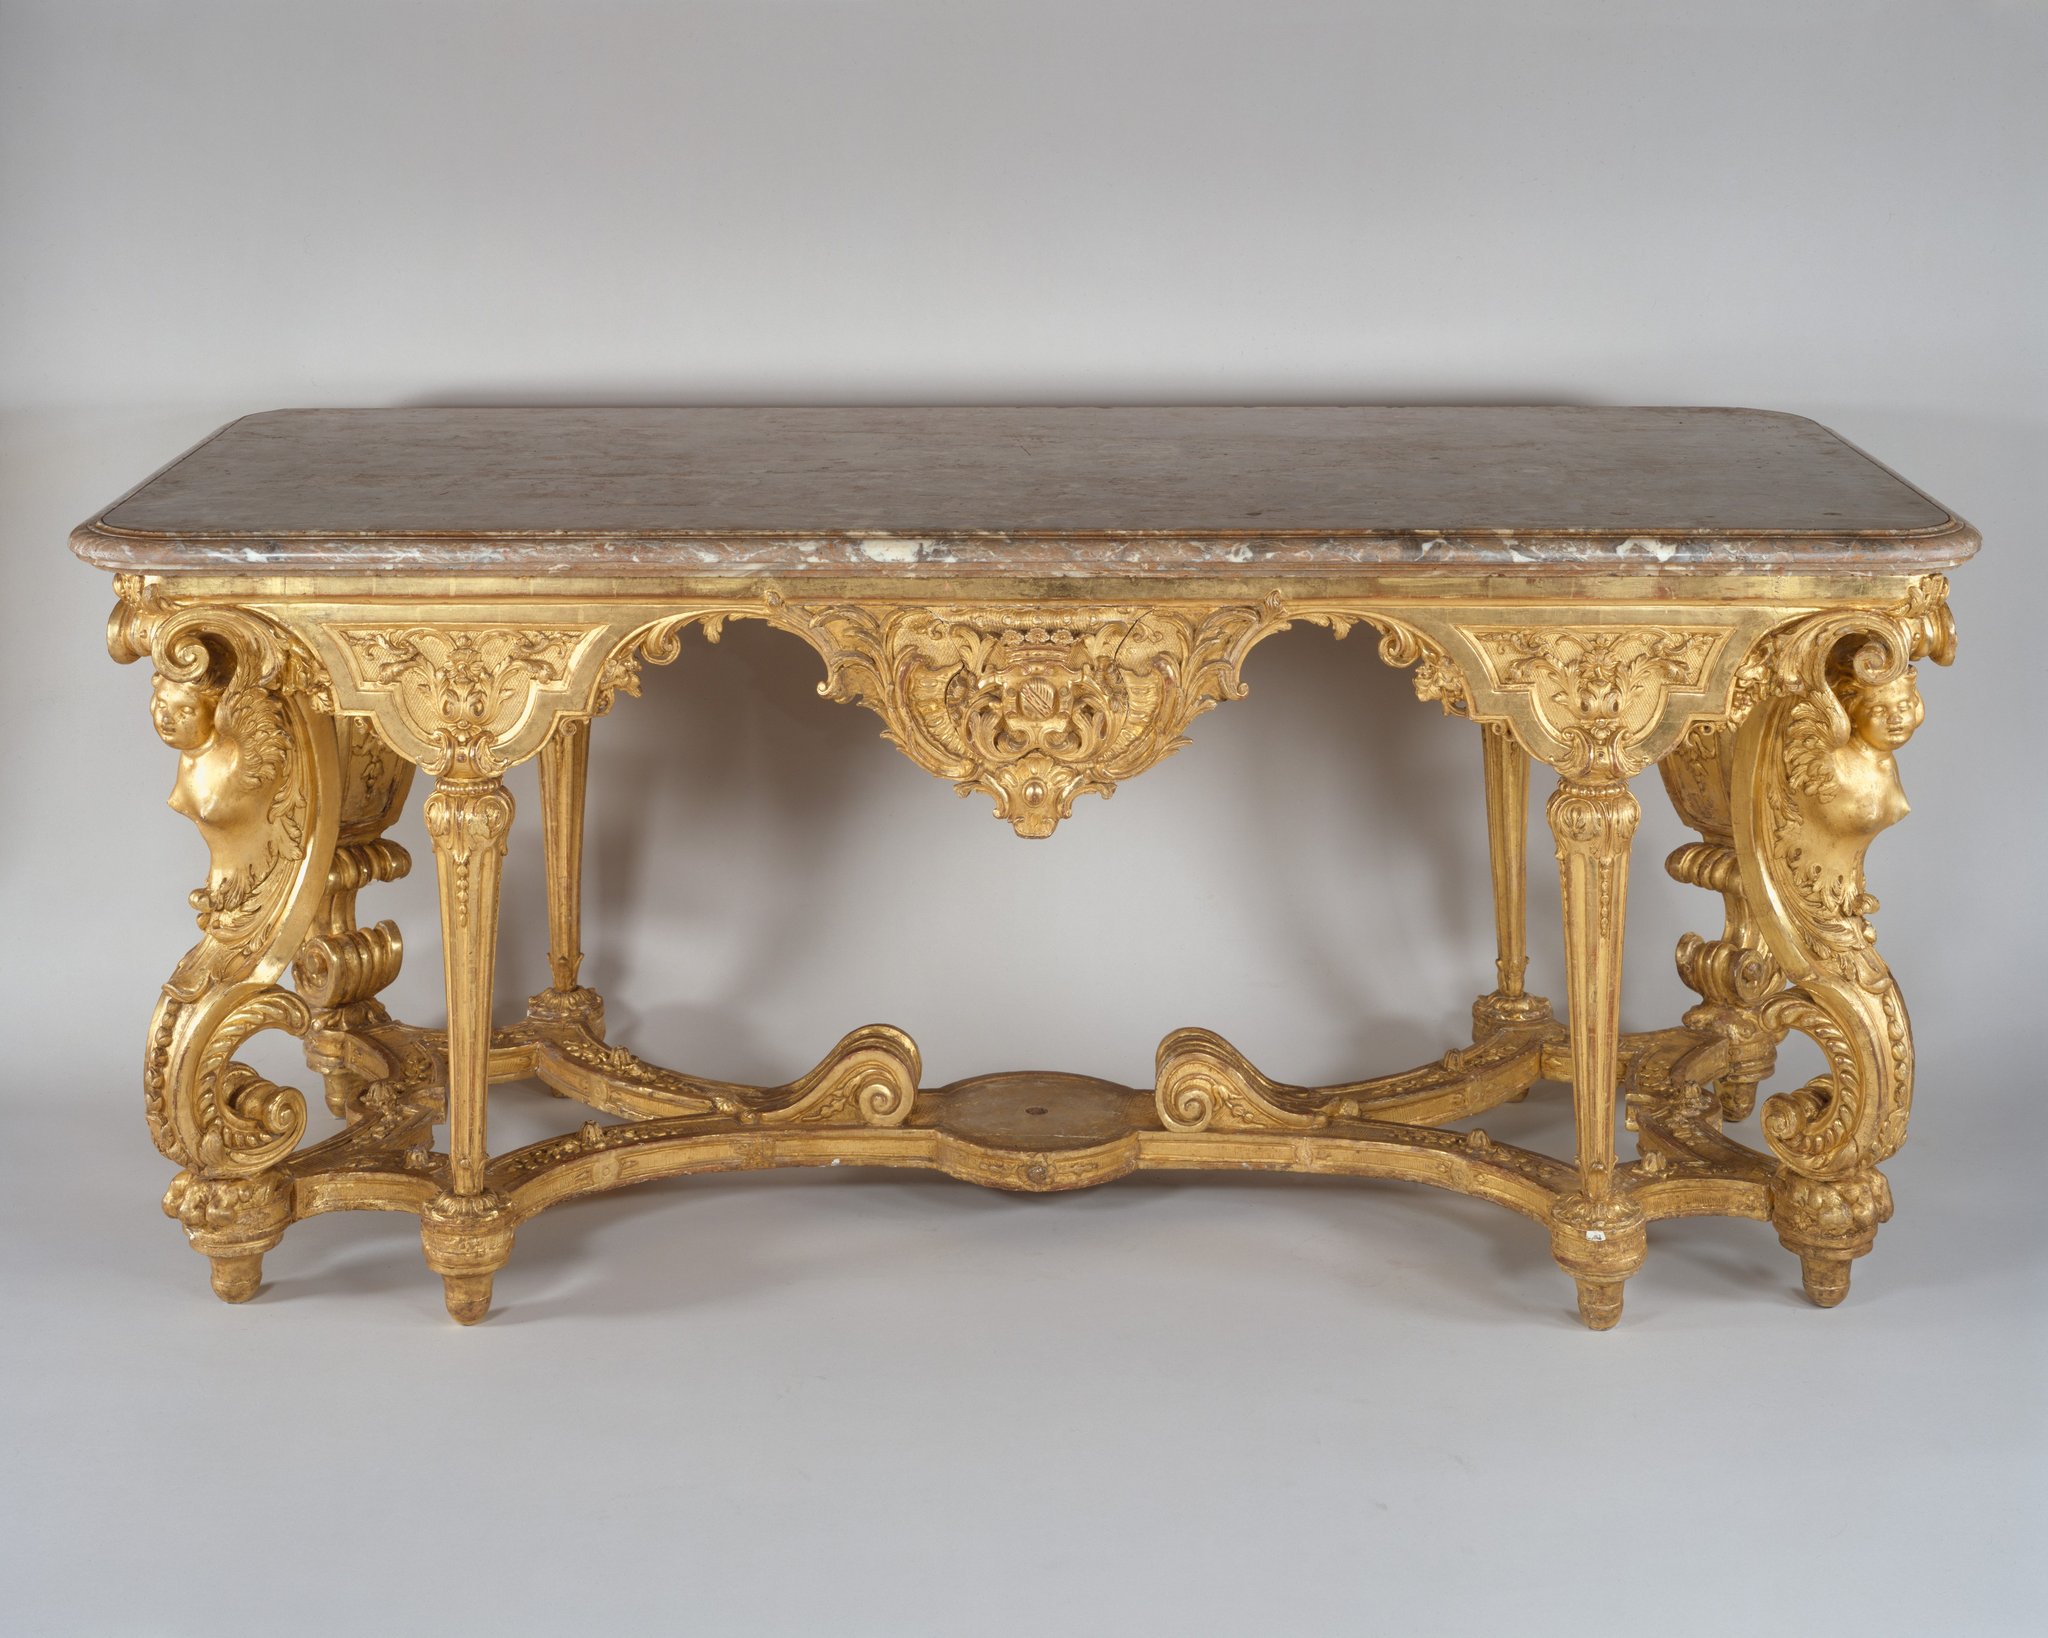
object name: side table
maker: charles lebrun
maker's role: designer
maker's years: 1619-1690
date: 1685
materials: marble, wood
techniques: carving, gilding